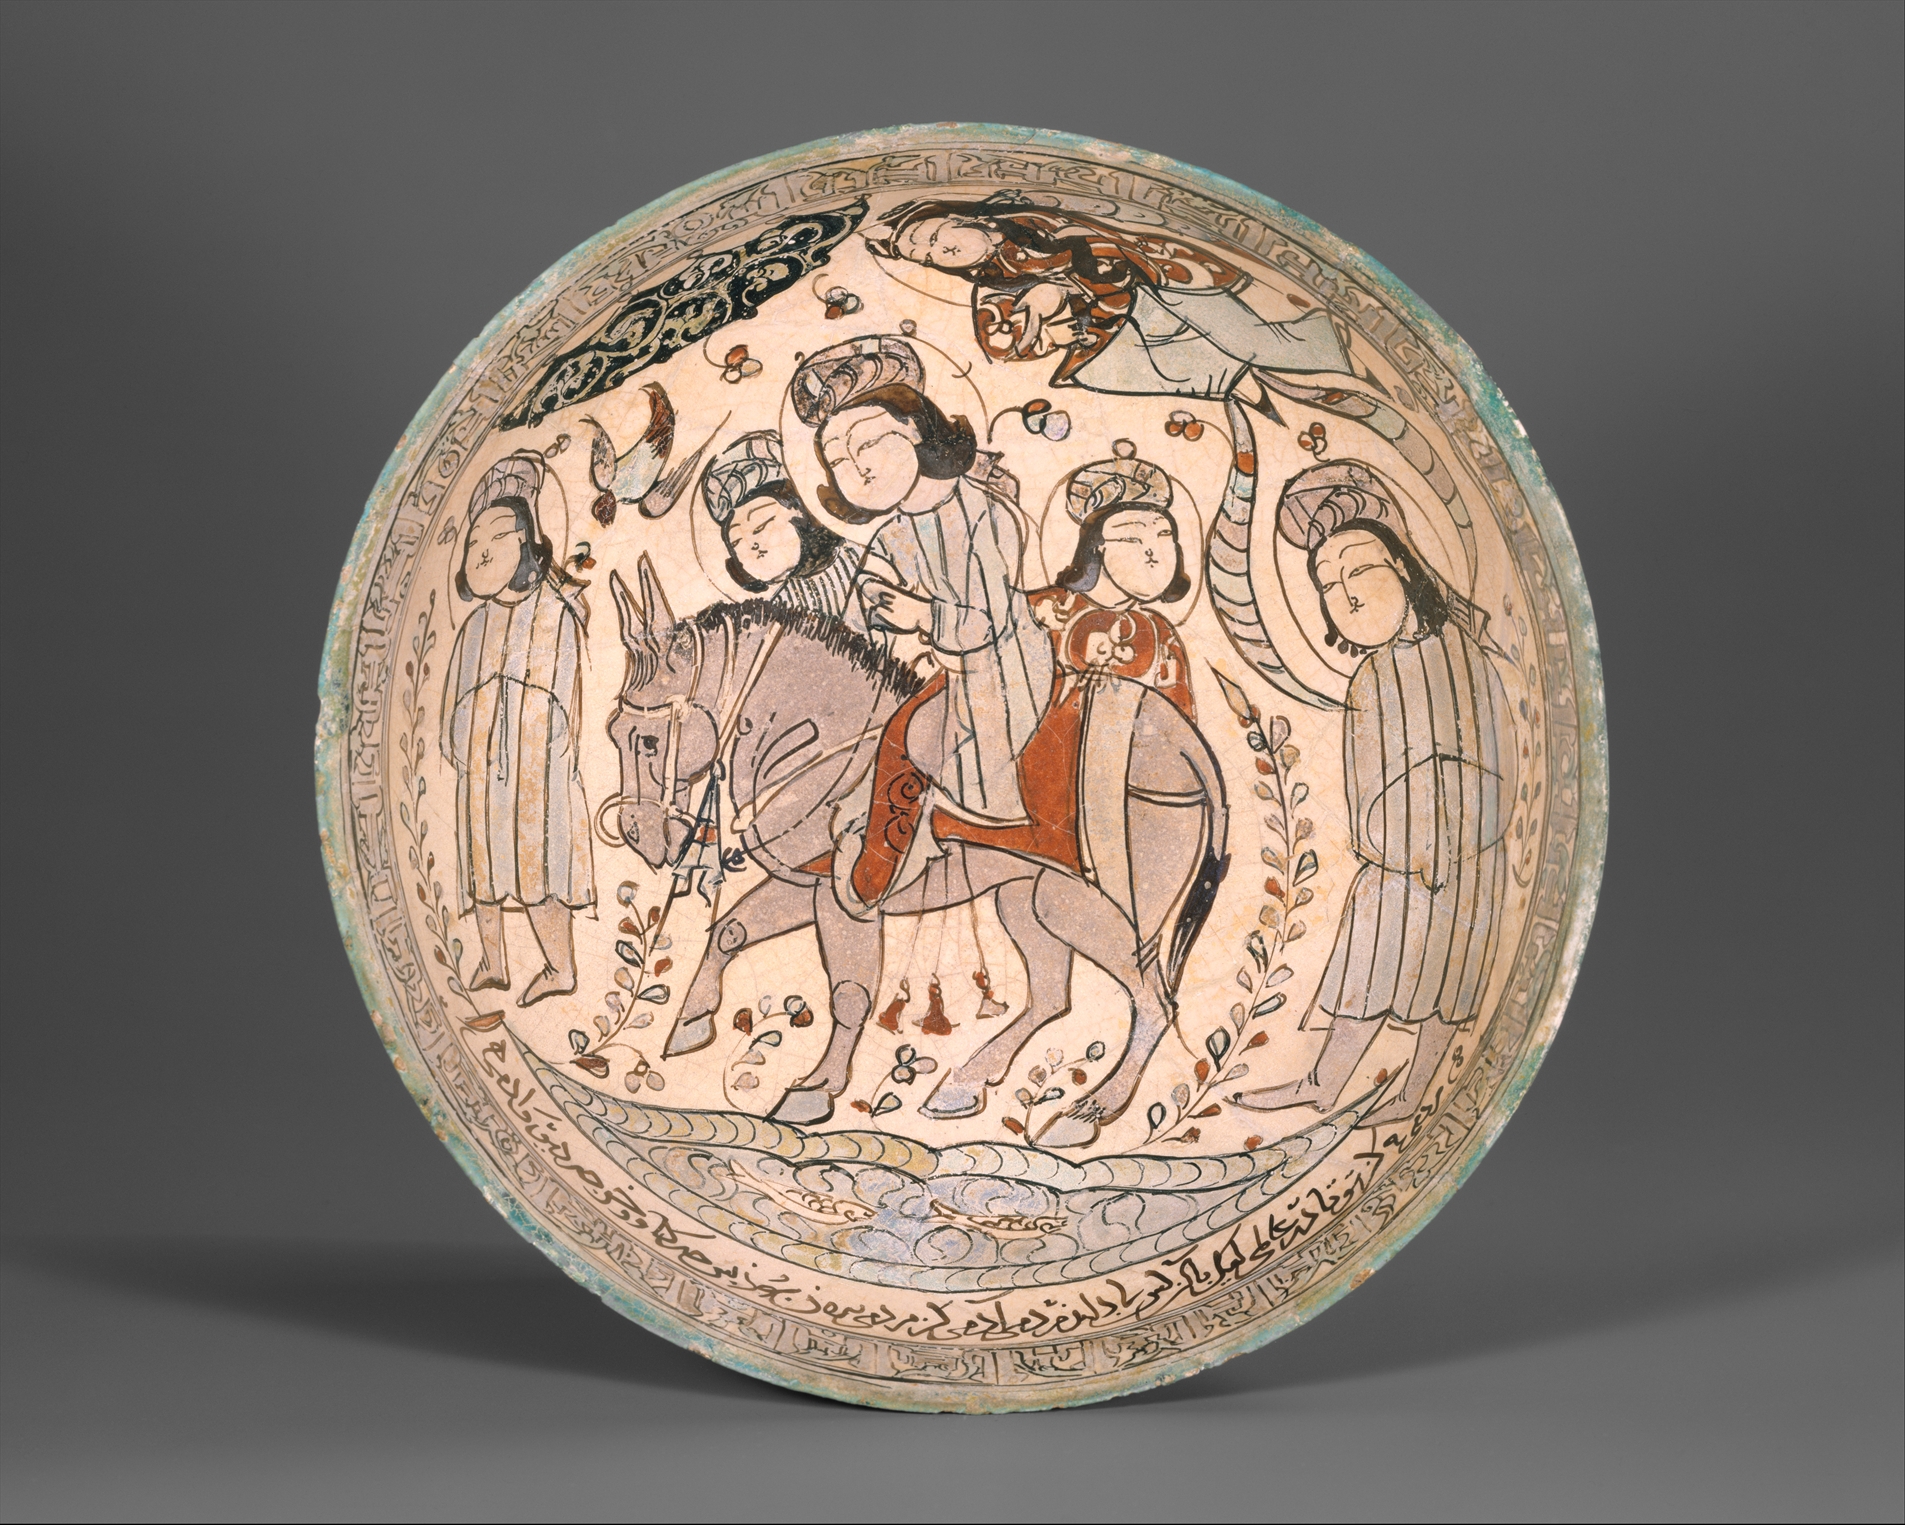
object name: bowl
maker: abu zayd al-kashani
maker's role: maker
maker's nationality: iranian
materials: glaze, stonepaste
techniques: overglaze, painting, polychrome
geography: iran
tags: birds,men,horses